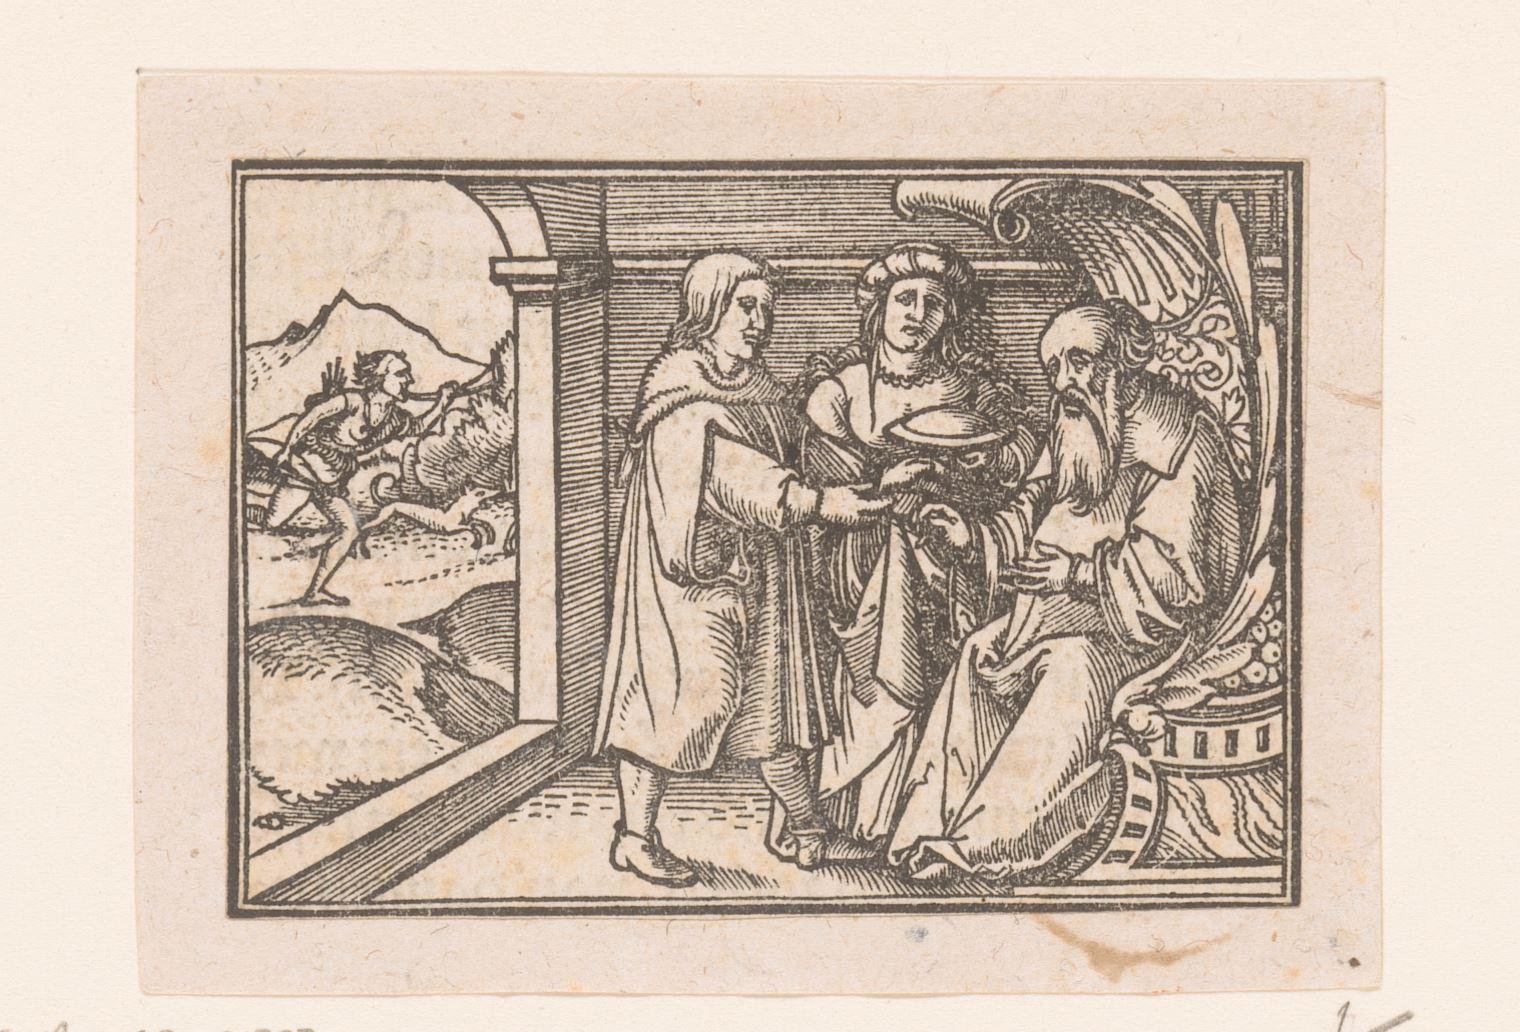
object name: print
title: Jacob bedriegt de blinde Isaak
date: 1522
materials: paper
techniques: woodcut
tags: isaac lying in bed blesses jacob who, disguised in esau's clothes, brings food to his father; jacob's hands and neck are covered with goatskins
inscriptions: collector's mark: Lugt 240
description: Mogelijk een kopie van een prent van Hans Holbein de jongere. Niet uit de Icones historiarum Veteris Testamenti van 1538. Deze kopie mogelijk uit: Biblia sacra iuxta vulgatam. Parijs: Jean Benoît, 1552. Ook aanwezig in de Herzog August Bibliothek: http://diglib.hab.de?grafik=graph-res-d-326-1.